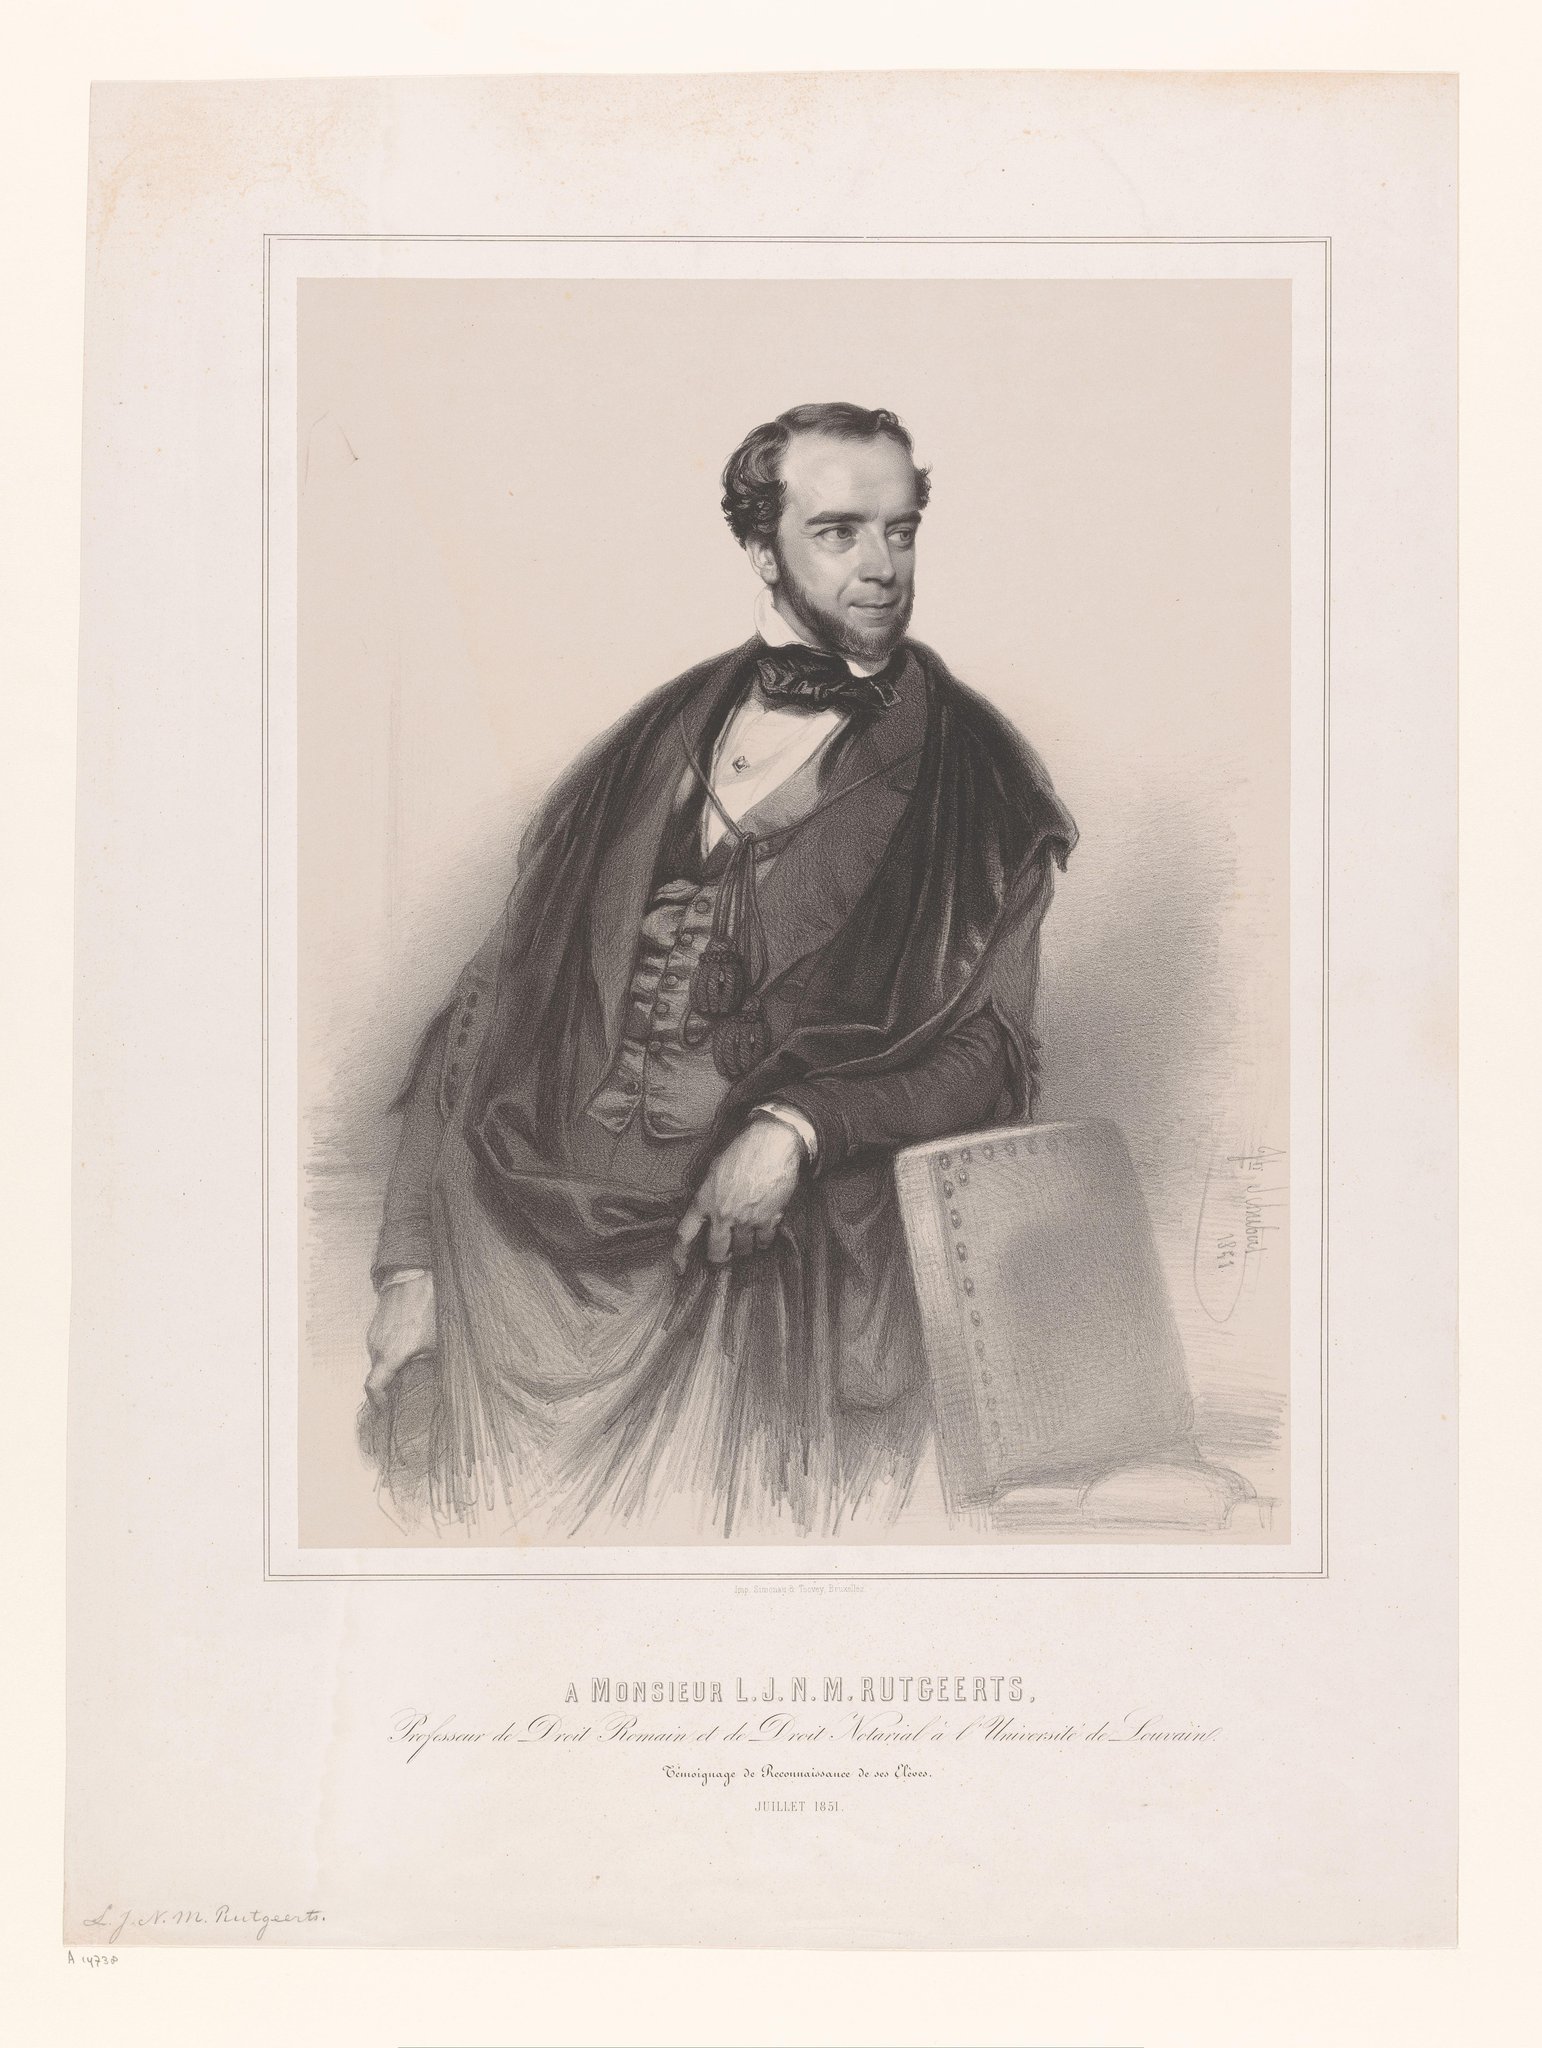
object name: print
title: Portret van Louis Joseph Napoleon Marie Rutgeerts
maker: joseph schubert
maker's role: print maker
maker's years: 1816-1885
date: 1851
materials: paper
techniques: lithograph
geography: brussels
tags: adult man, historical persons, leaning figure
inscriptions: collector's mark: Lugt 2228